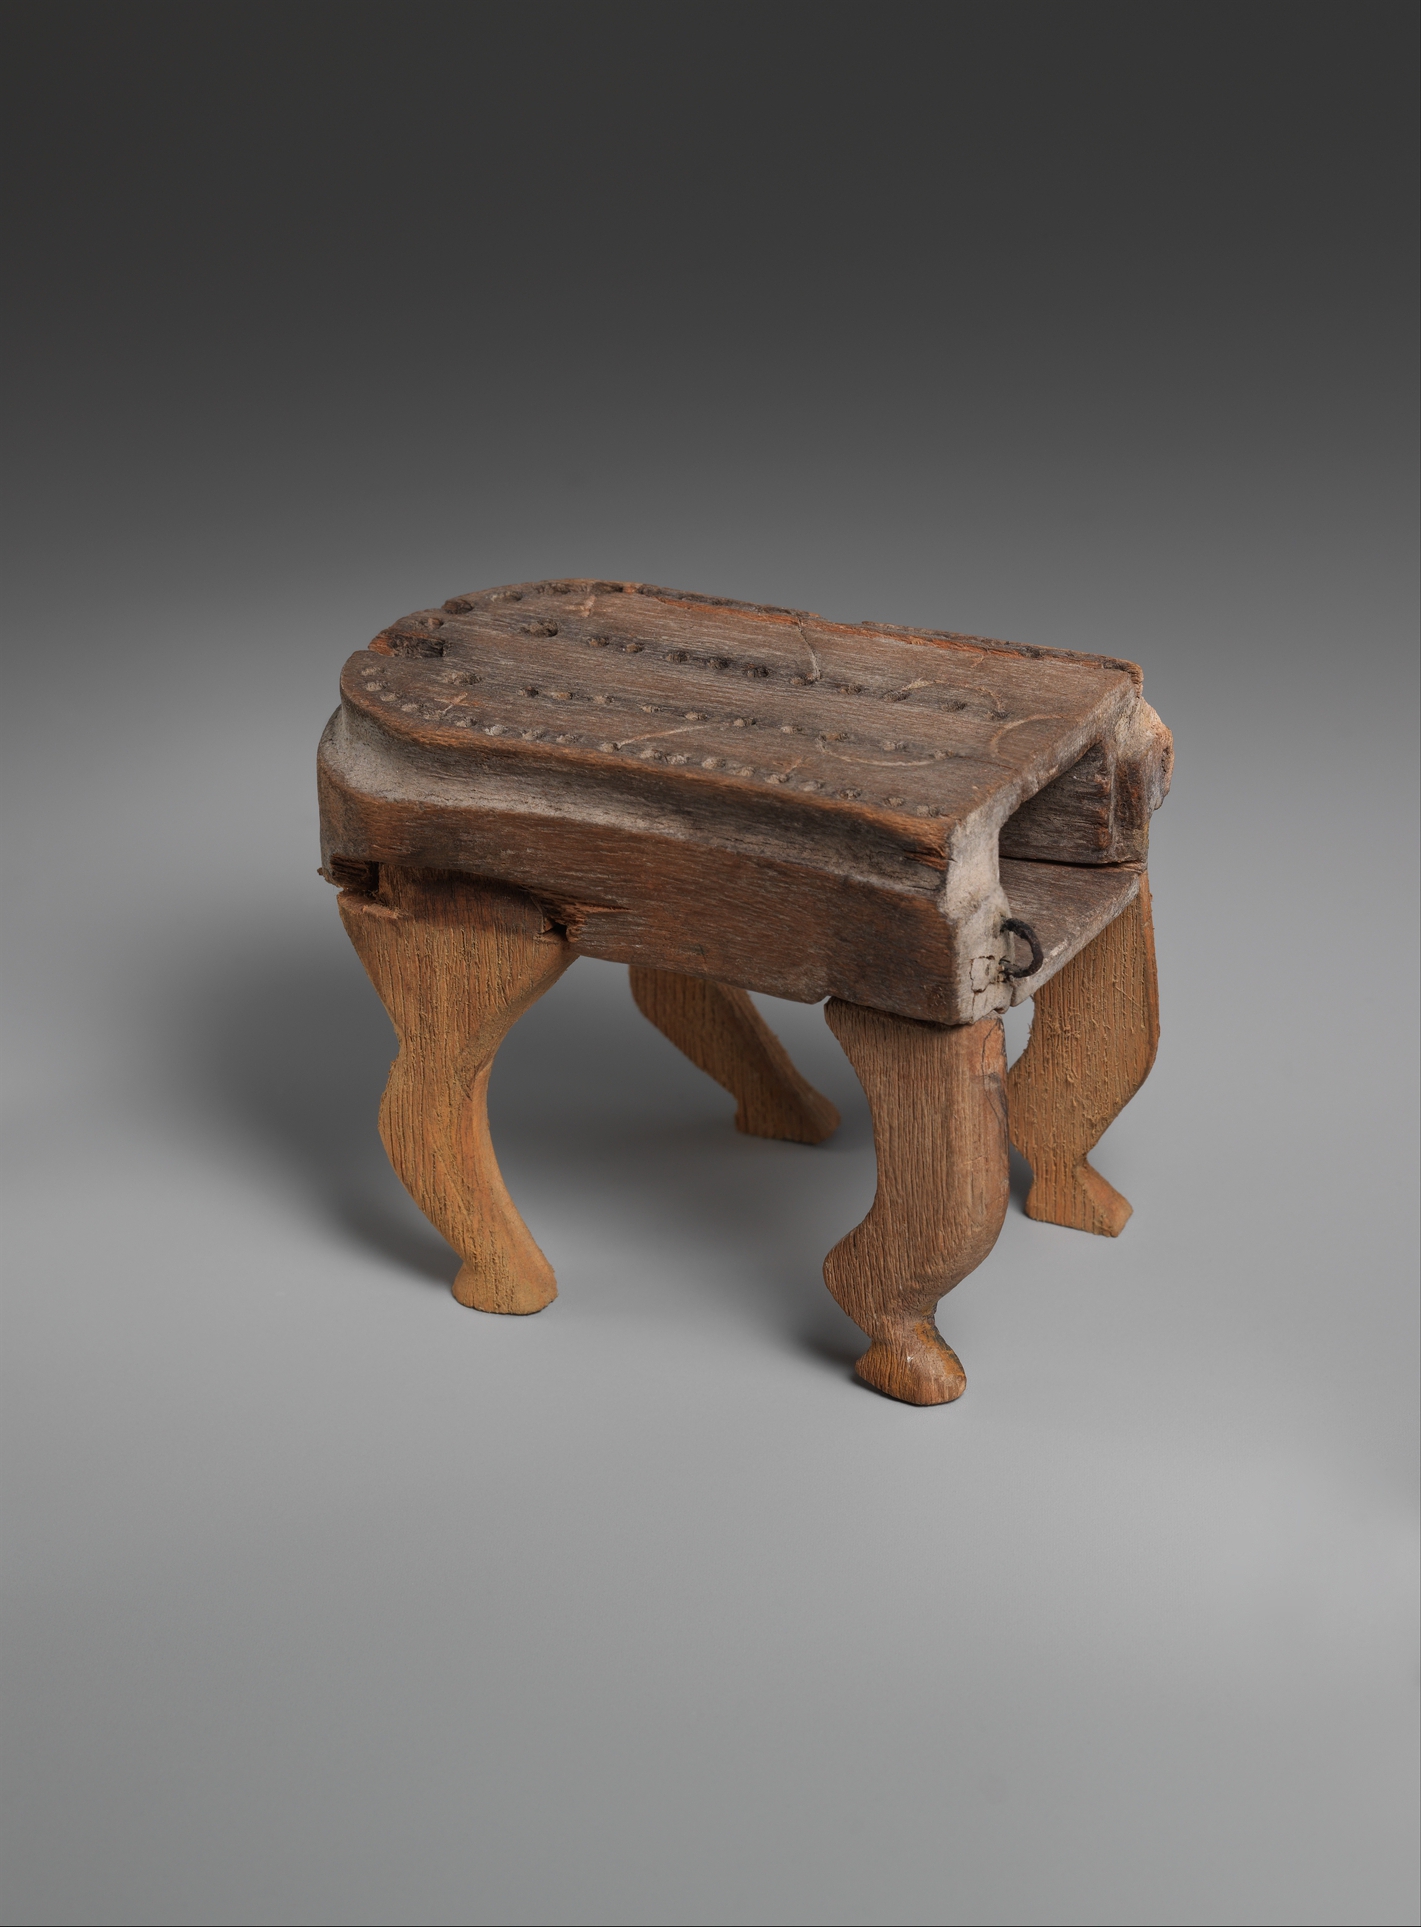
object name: game board, hound jackal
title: Small Hounds & Jackals Game Board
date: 2030-1640 BCE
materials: paint, wood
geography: egypt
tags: games